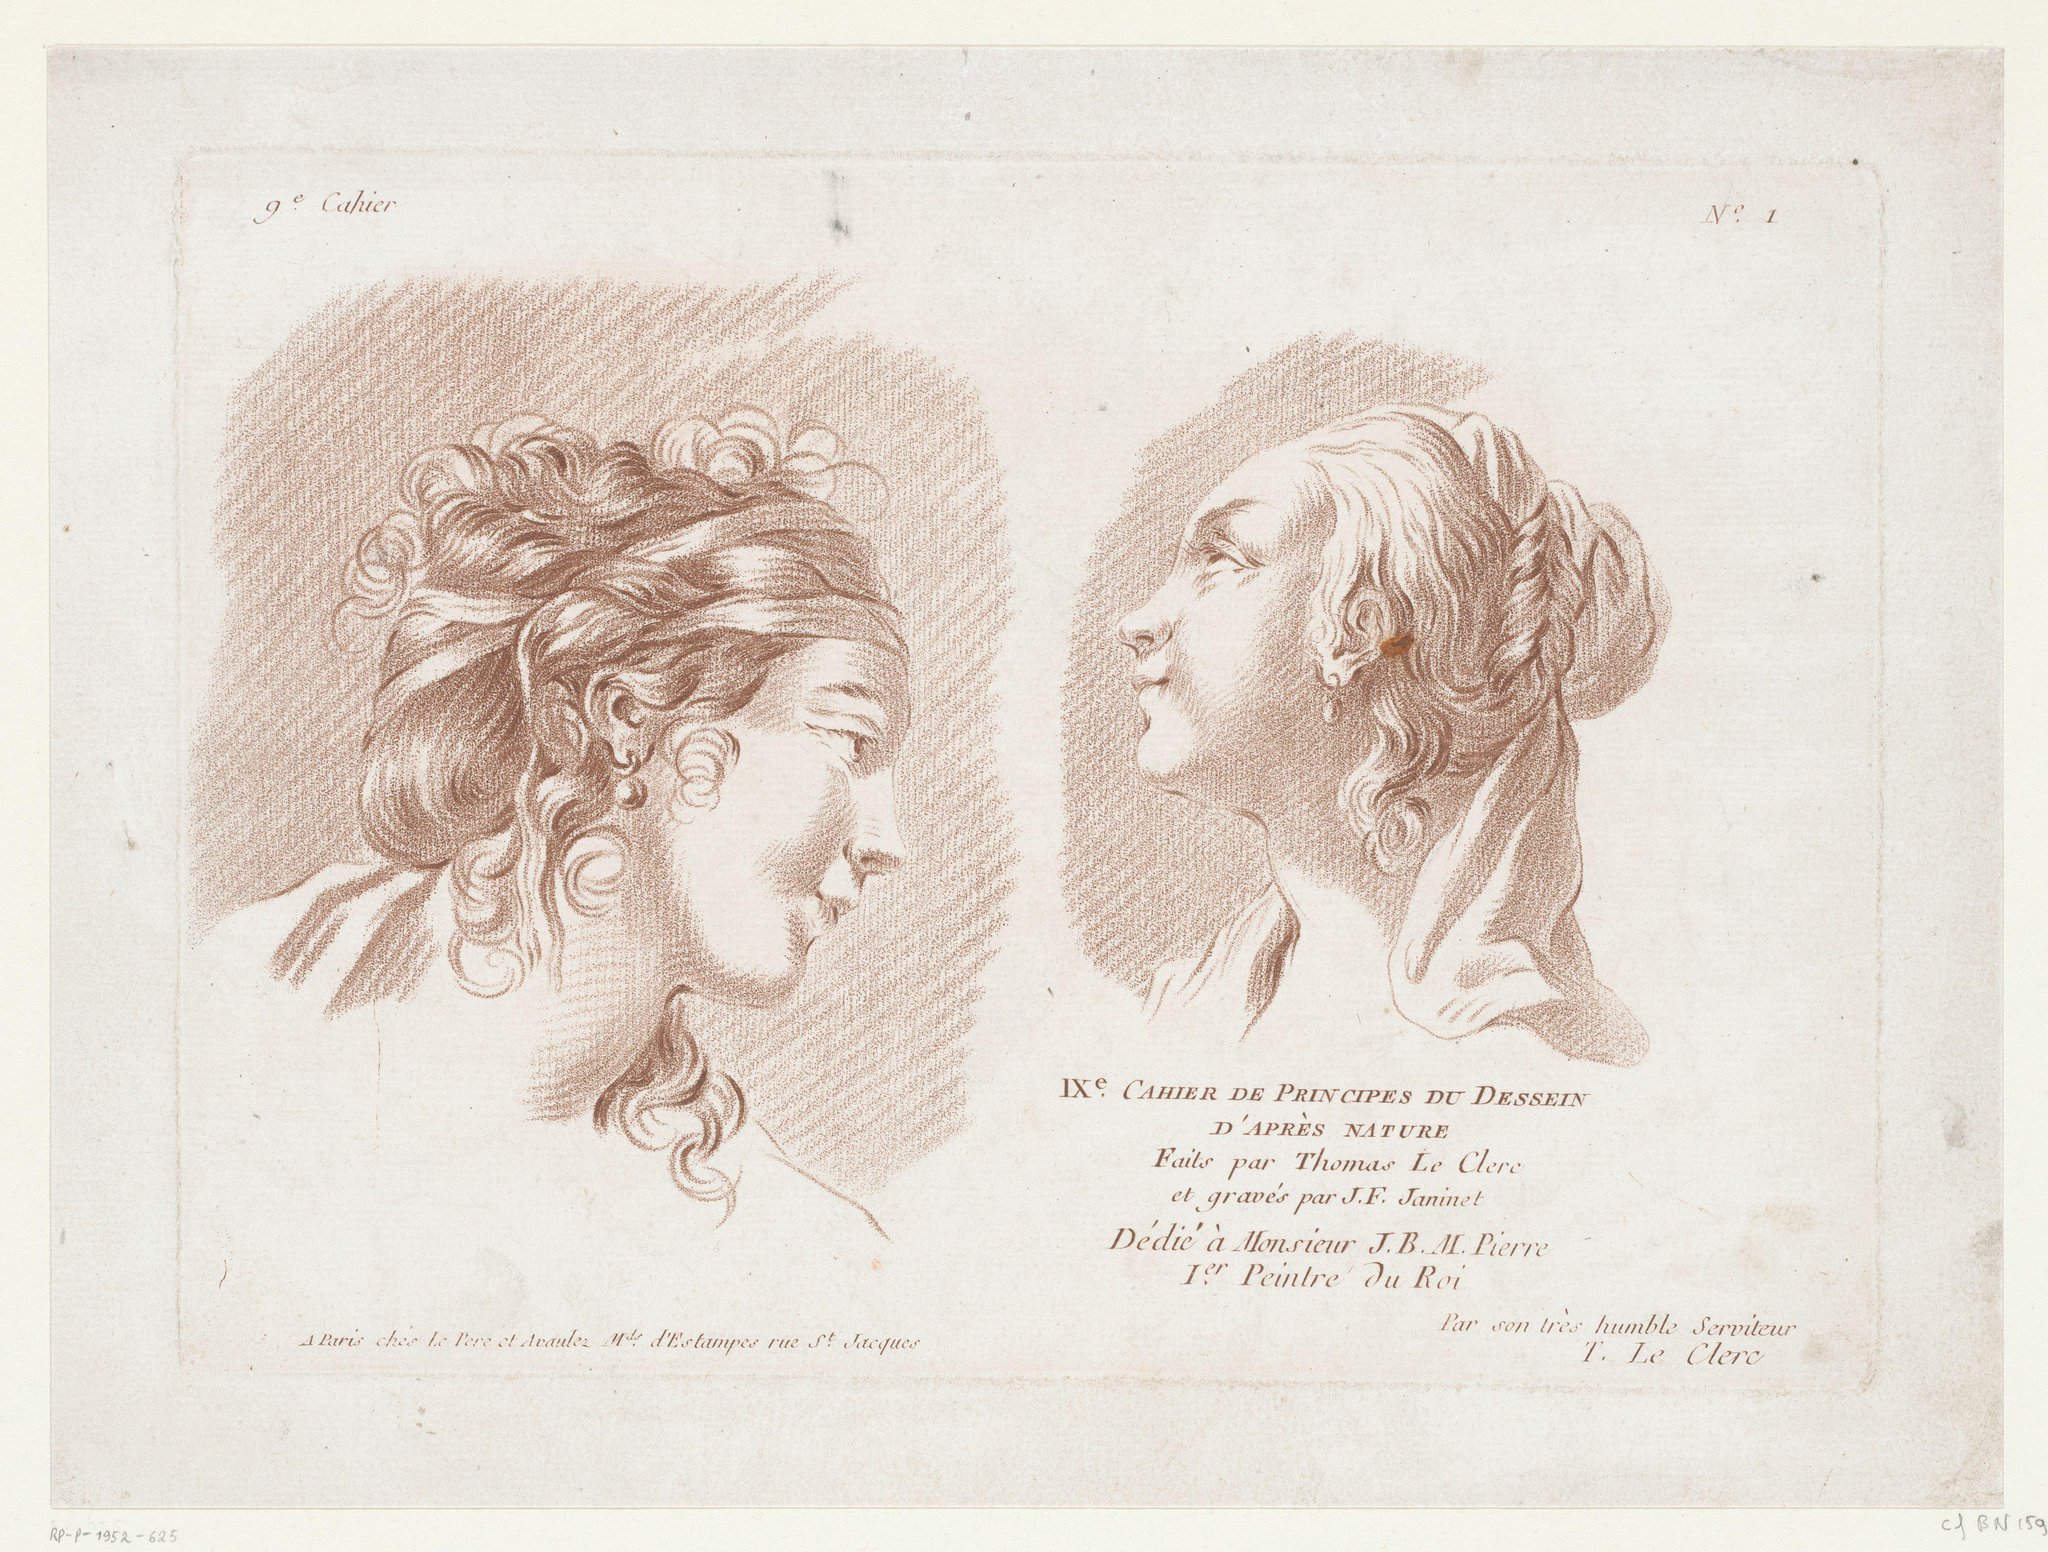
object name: print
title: Composities met menselijke lichaamsdelen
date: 1773-1777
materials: paper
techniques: printmaking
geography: france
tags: head (human) - aa - female human figure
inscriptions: watermark, collector's mark: Lugt 2228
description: Deze prent maakt deel uit van een album dat uit minstens elf delen bestaat. Dit is het eerste blad van het negende album. Waarschijnlijk dienden deze albums als voorbeeld voor tekenaars, schilders en graveurs.